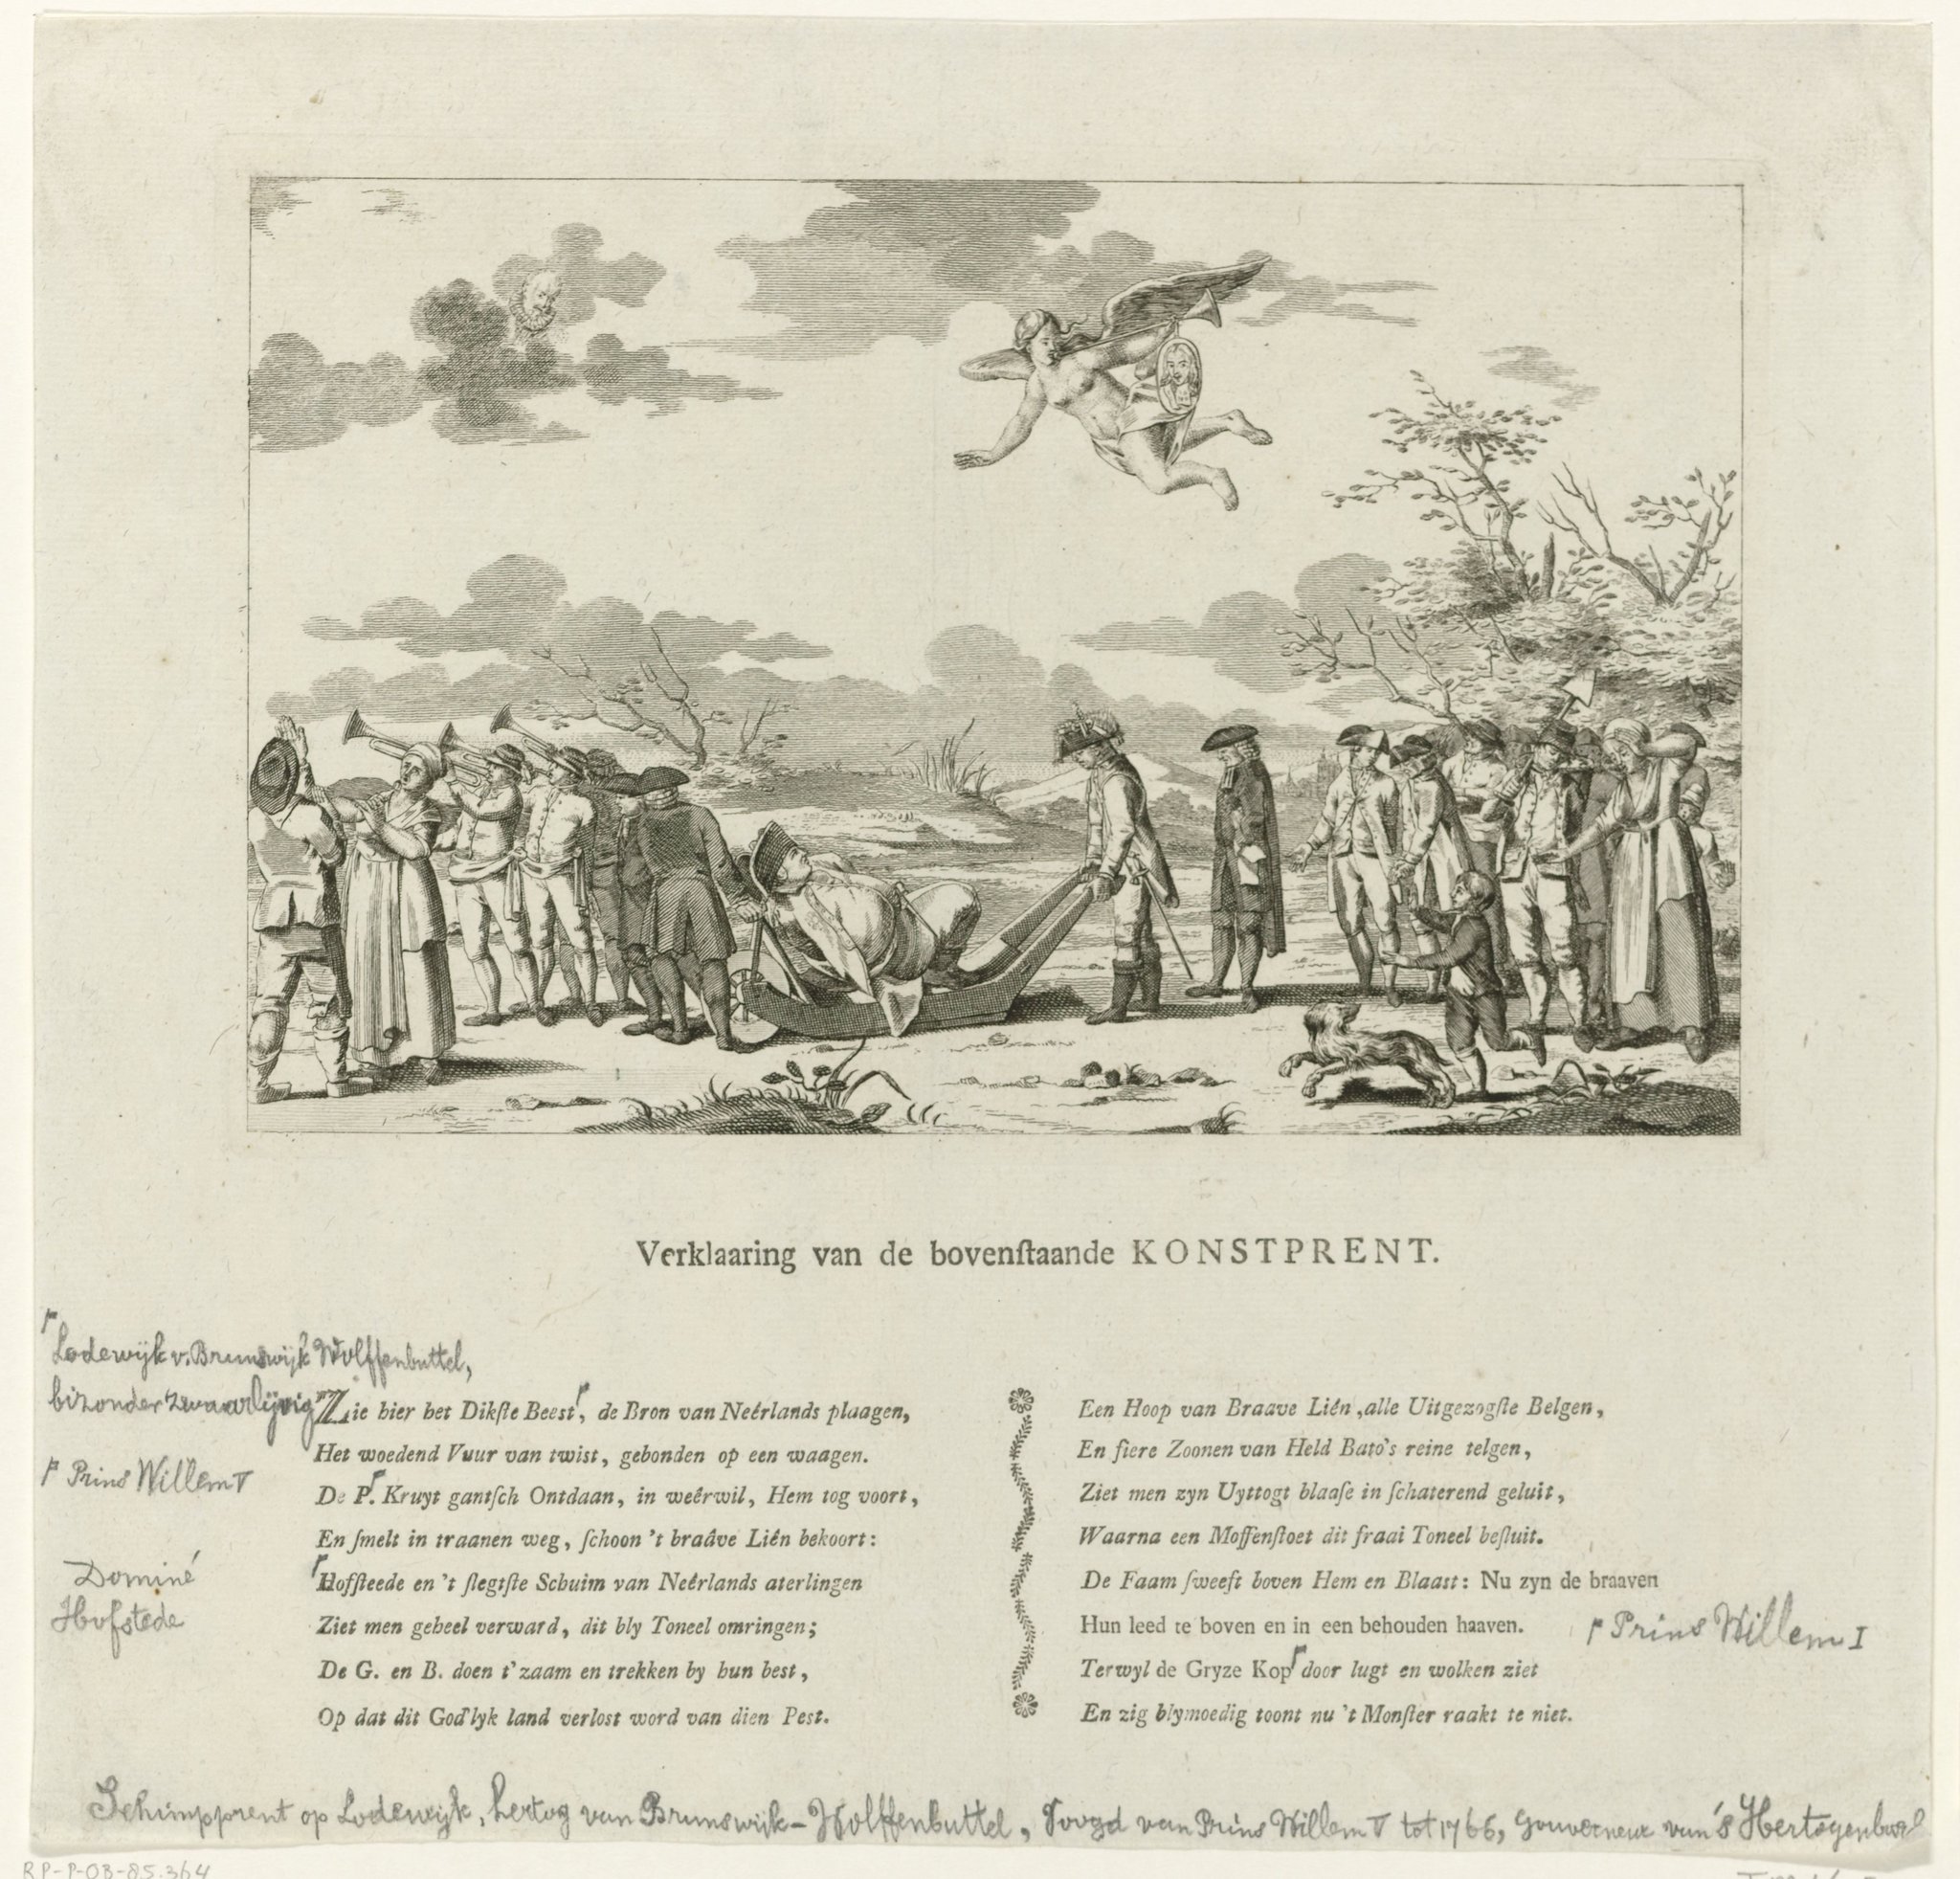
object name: cartoon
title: Spotprent met het wegkruien van de hertog van Brunswijk uit Nederland, 1784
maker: Anonymous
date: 1784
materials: paper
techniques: engraving, etching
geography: northern netherlands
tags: the hague, william v (prince of orange), ludwig ernst von braunschweig-wolfenbüttel, kaat mossel, wheelbarrow, patriots (1780-1795)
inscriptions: collector's mark: Lugt 2228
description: Spotprent op het vertrek van de hertog van Brunswijk uit Nederland, 14 oktober 1784. De dikke hertog wordt door prins Willem V op een kruiwagen het land uitgekruid. In het gevolg van de prins o.a. Kaat Mossel. Vanuit de wolken kijkt Van Oldenbarnevelt toe terwijl de Faam op haar bazuin blaast. Op het blad onder de plaat een verklaring van de voorstelling in twee kolommen in rijmvorm. Bij de prent behoort een blad met twee puntdichten.